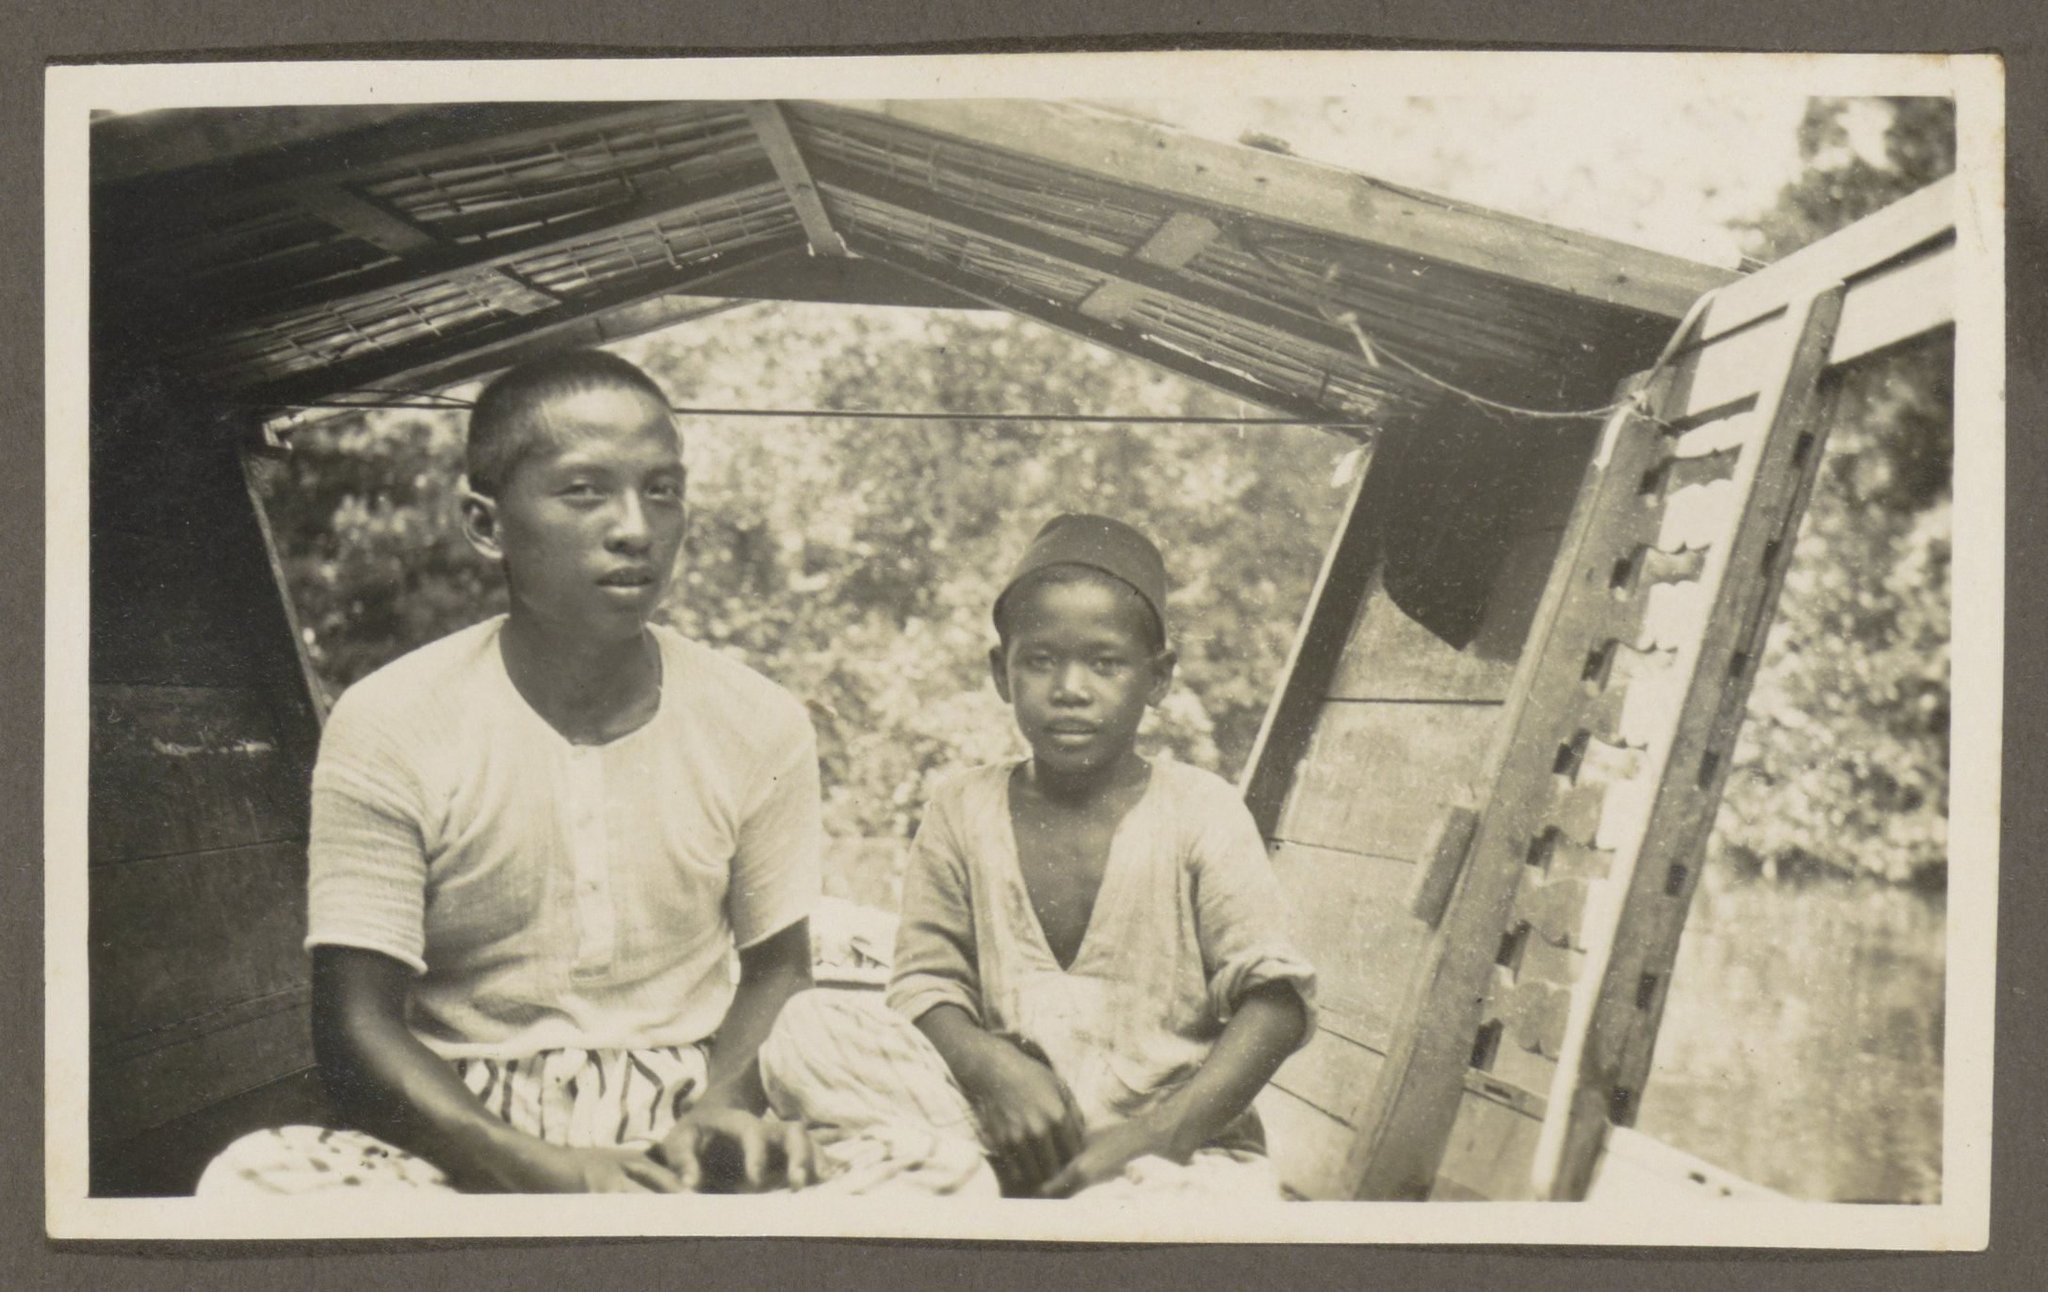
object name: photograph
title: Twee Indische jongens zittend in overkapte houten boot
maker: Anonymous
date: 1920-1930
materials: photographic support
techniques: gelatin silver print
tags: dutch east indies, the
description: Onderdeel van familiealbum Nederlands-Indië.